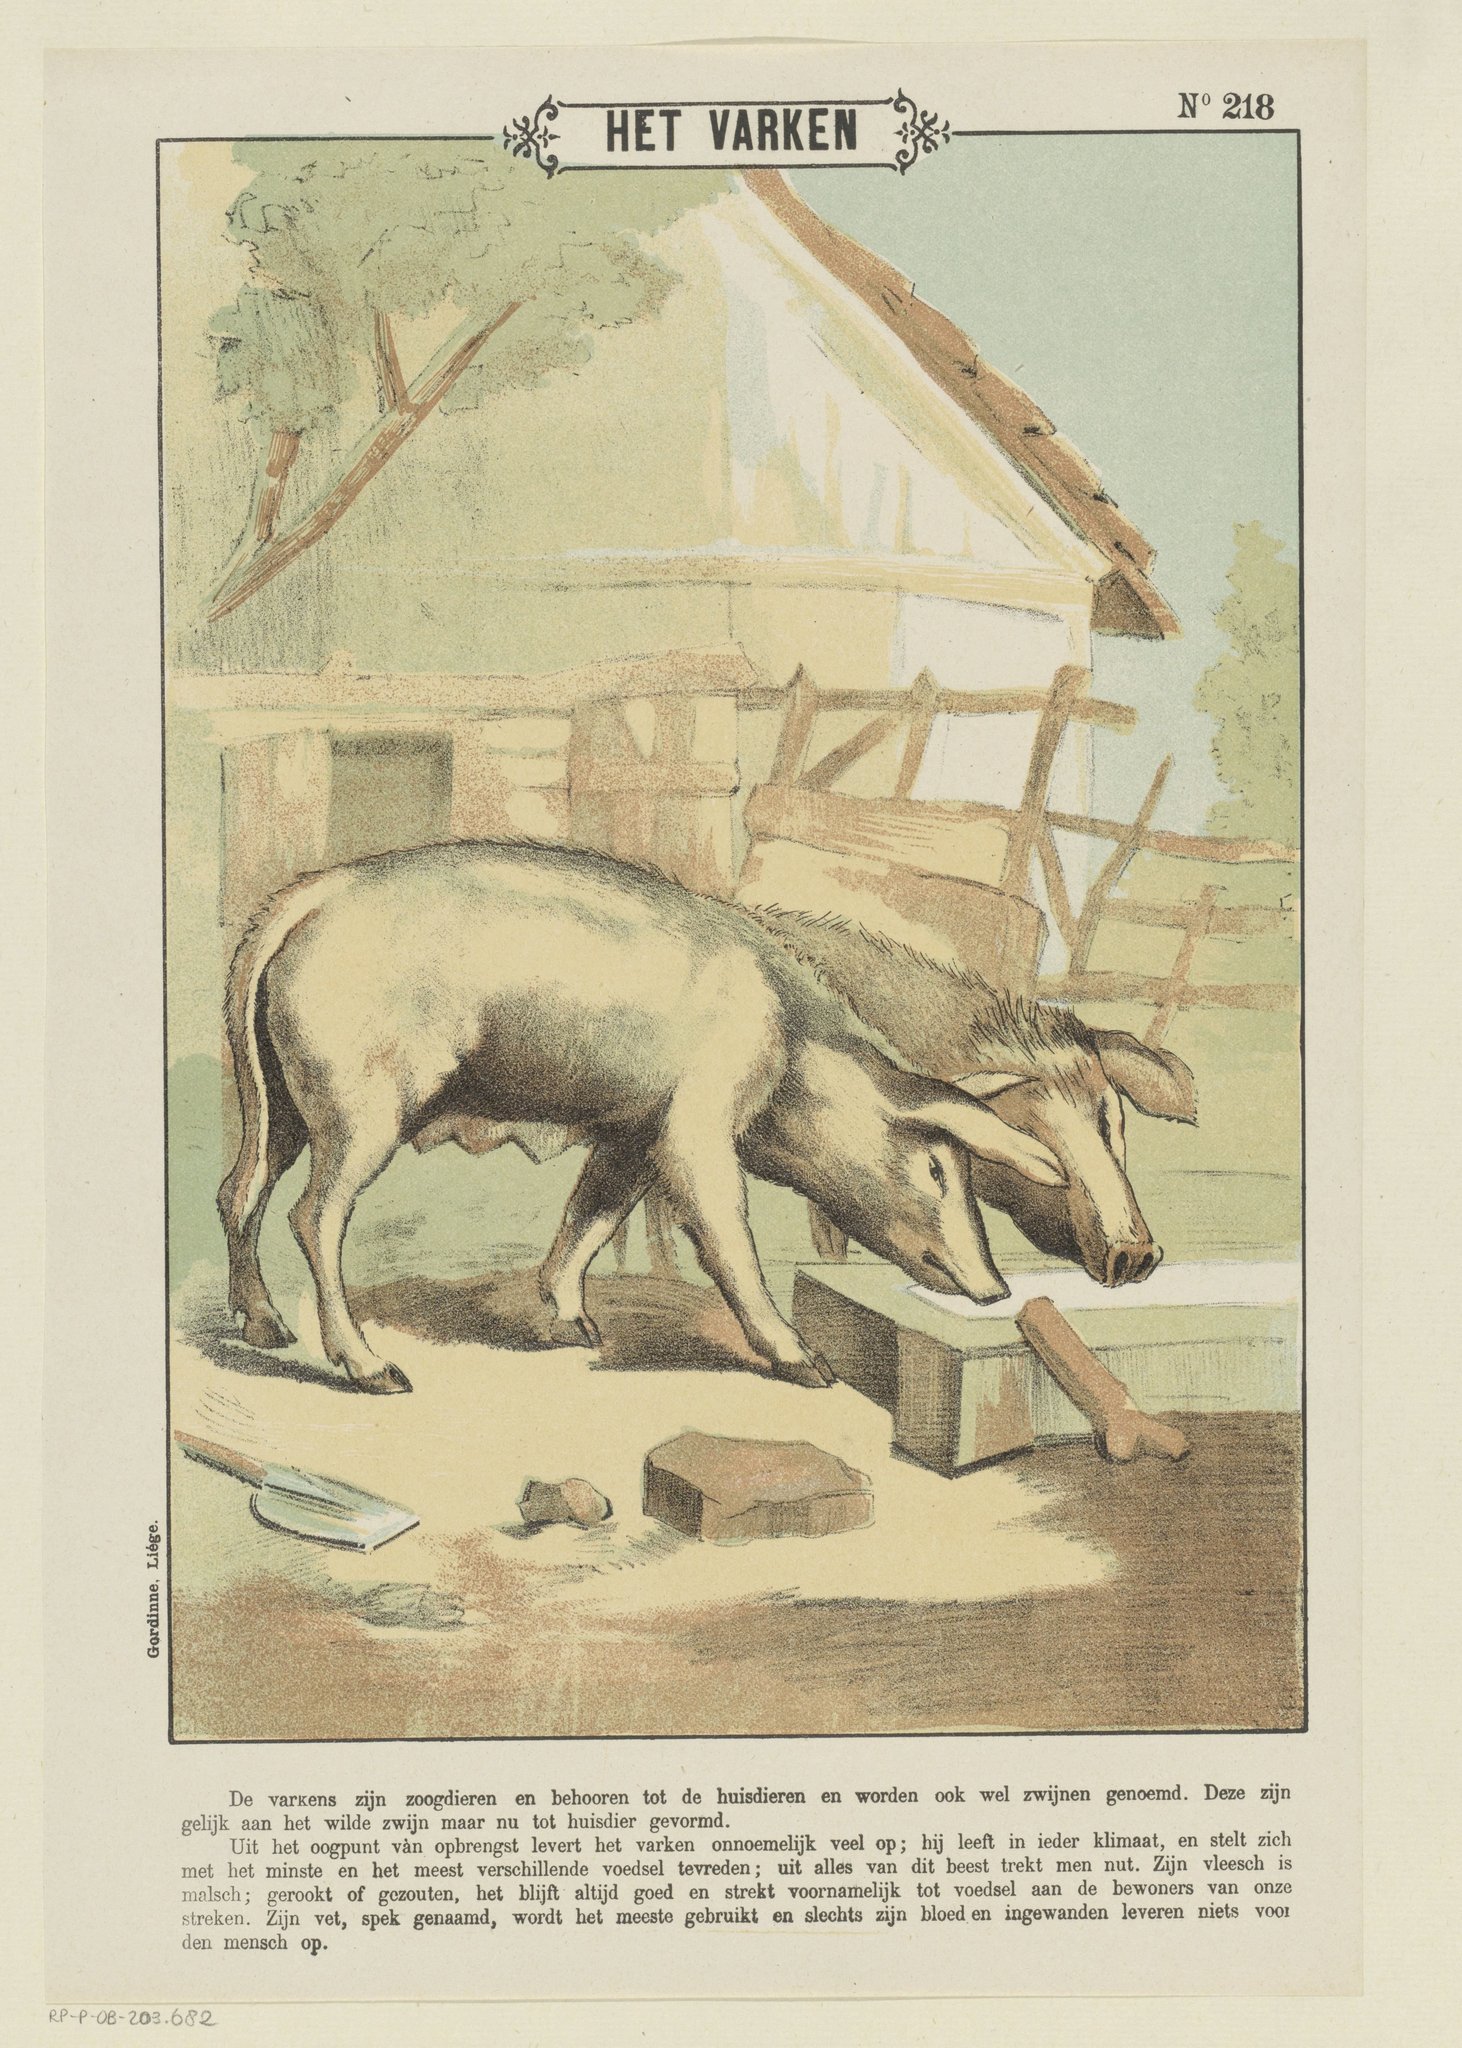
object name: print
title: Het varken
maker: Anonymous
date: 1894-1959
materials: paper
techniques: lithograph, letterpress printing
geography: liège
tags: pig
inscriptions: collector's mark: Lugt 2760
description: Blad met een grote voorstelling van twee varkens bij een voederbak. Op de achtergrond een boerderij. In de ondermarge een onderschrift. Genummerd rechtsboven: No 218.